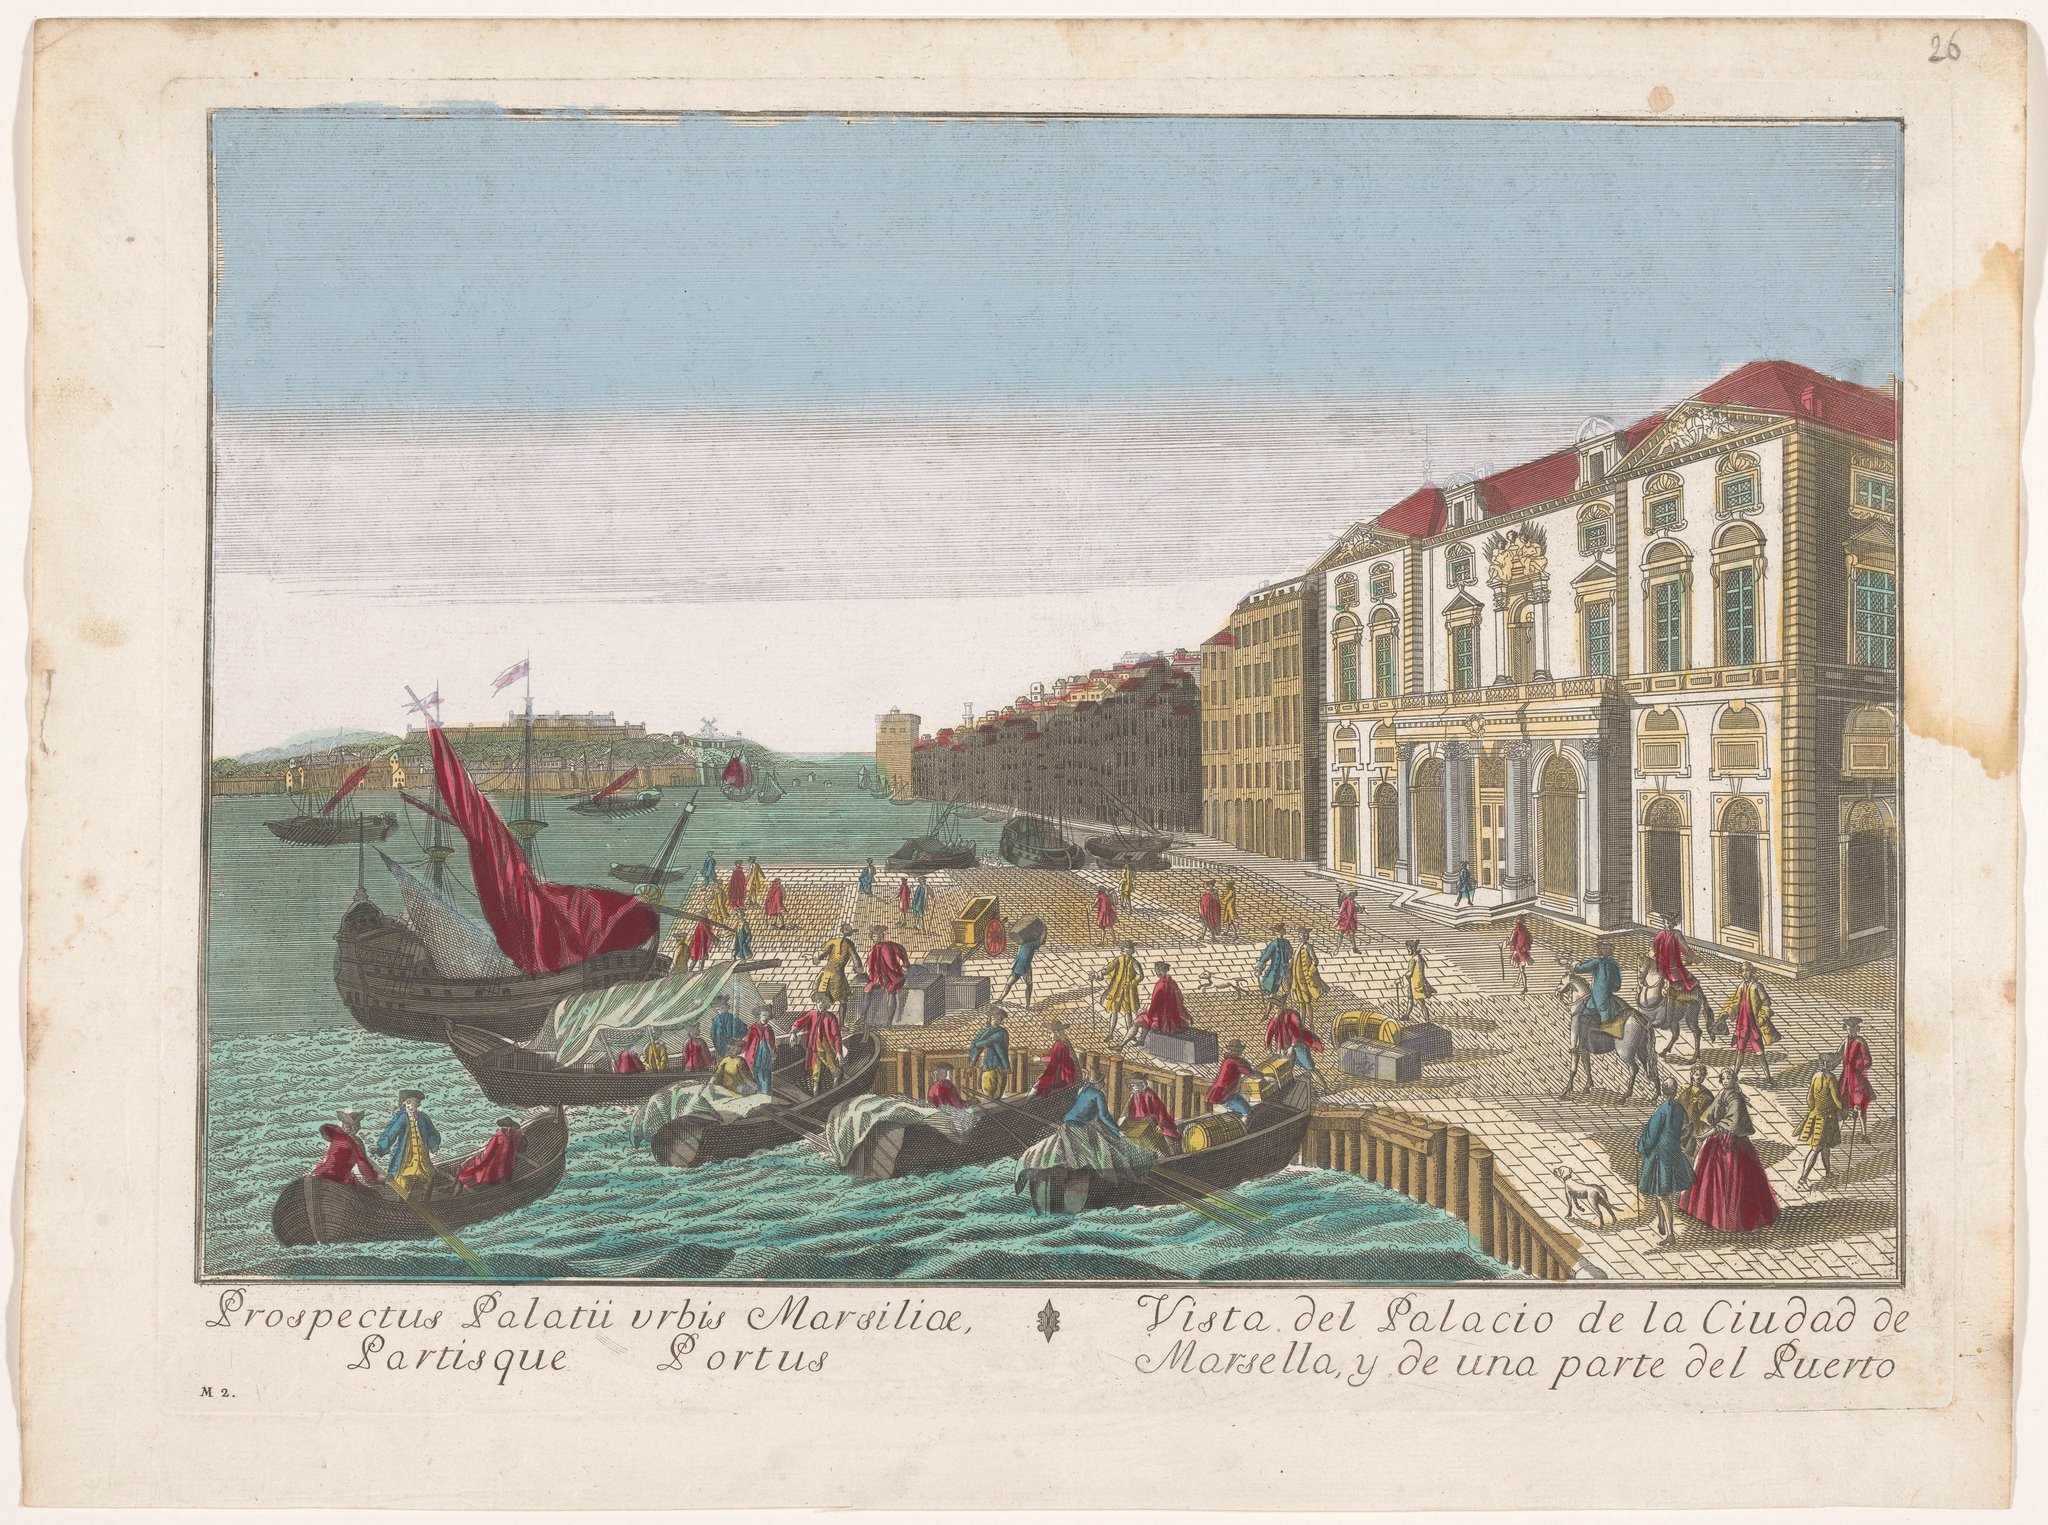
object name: print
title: Vista del Palacio de la Ciudad de Marsella, y de una parte del puerto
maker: Anonymous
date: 1700-1799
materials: paper, watercolor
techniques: brush, etching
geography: bassano del grappa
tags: harbour, sailing-ship, sailing-boat, rowing-boat, canoe, etc., townhall, sea (seascape) (+ landscape with figures, staffage), marseille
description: Op het water liggen schepen en boten. Rechts staan groepen figuren met goederen aan de waterkant. Linksonder genummerd: M 2.